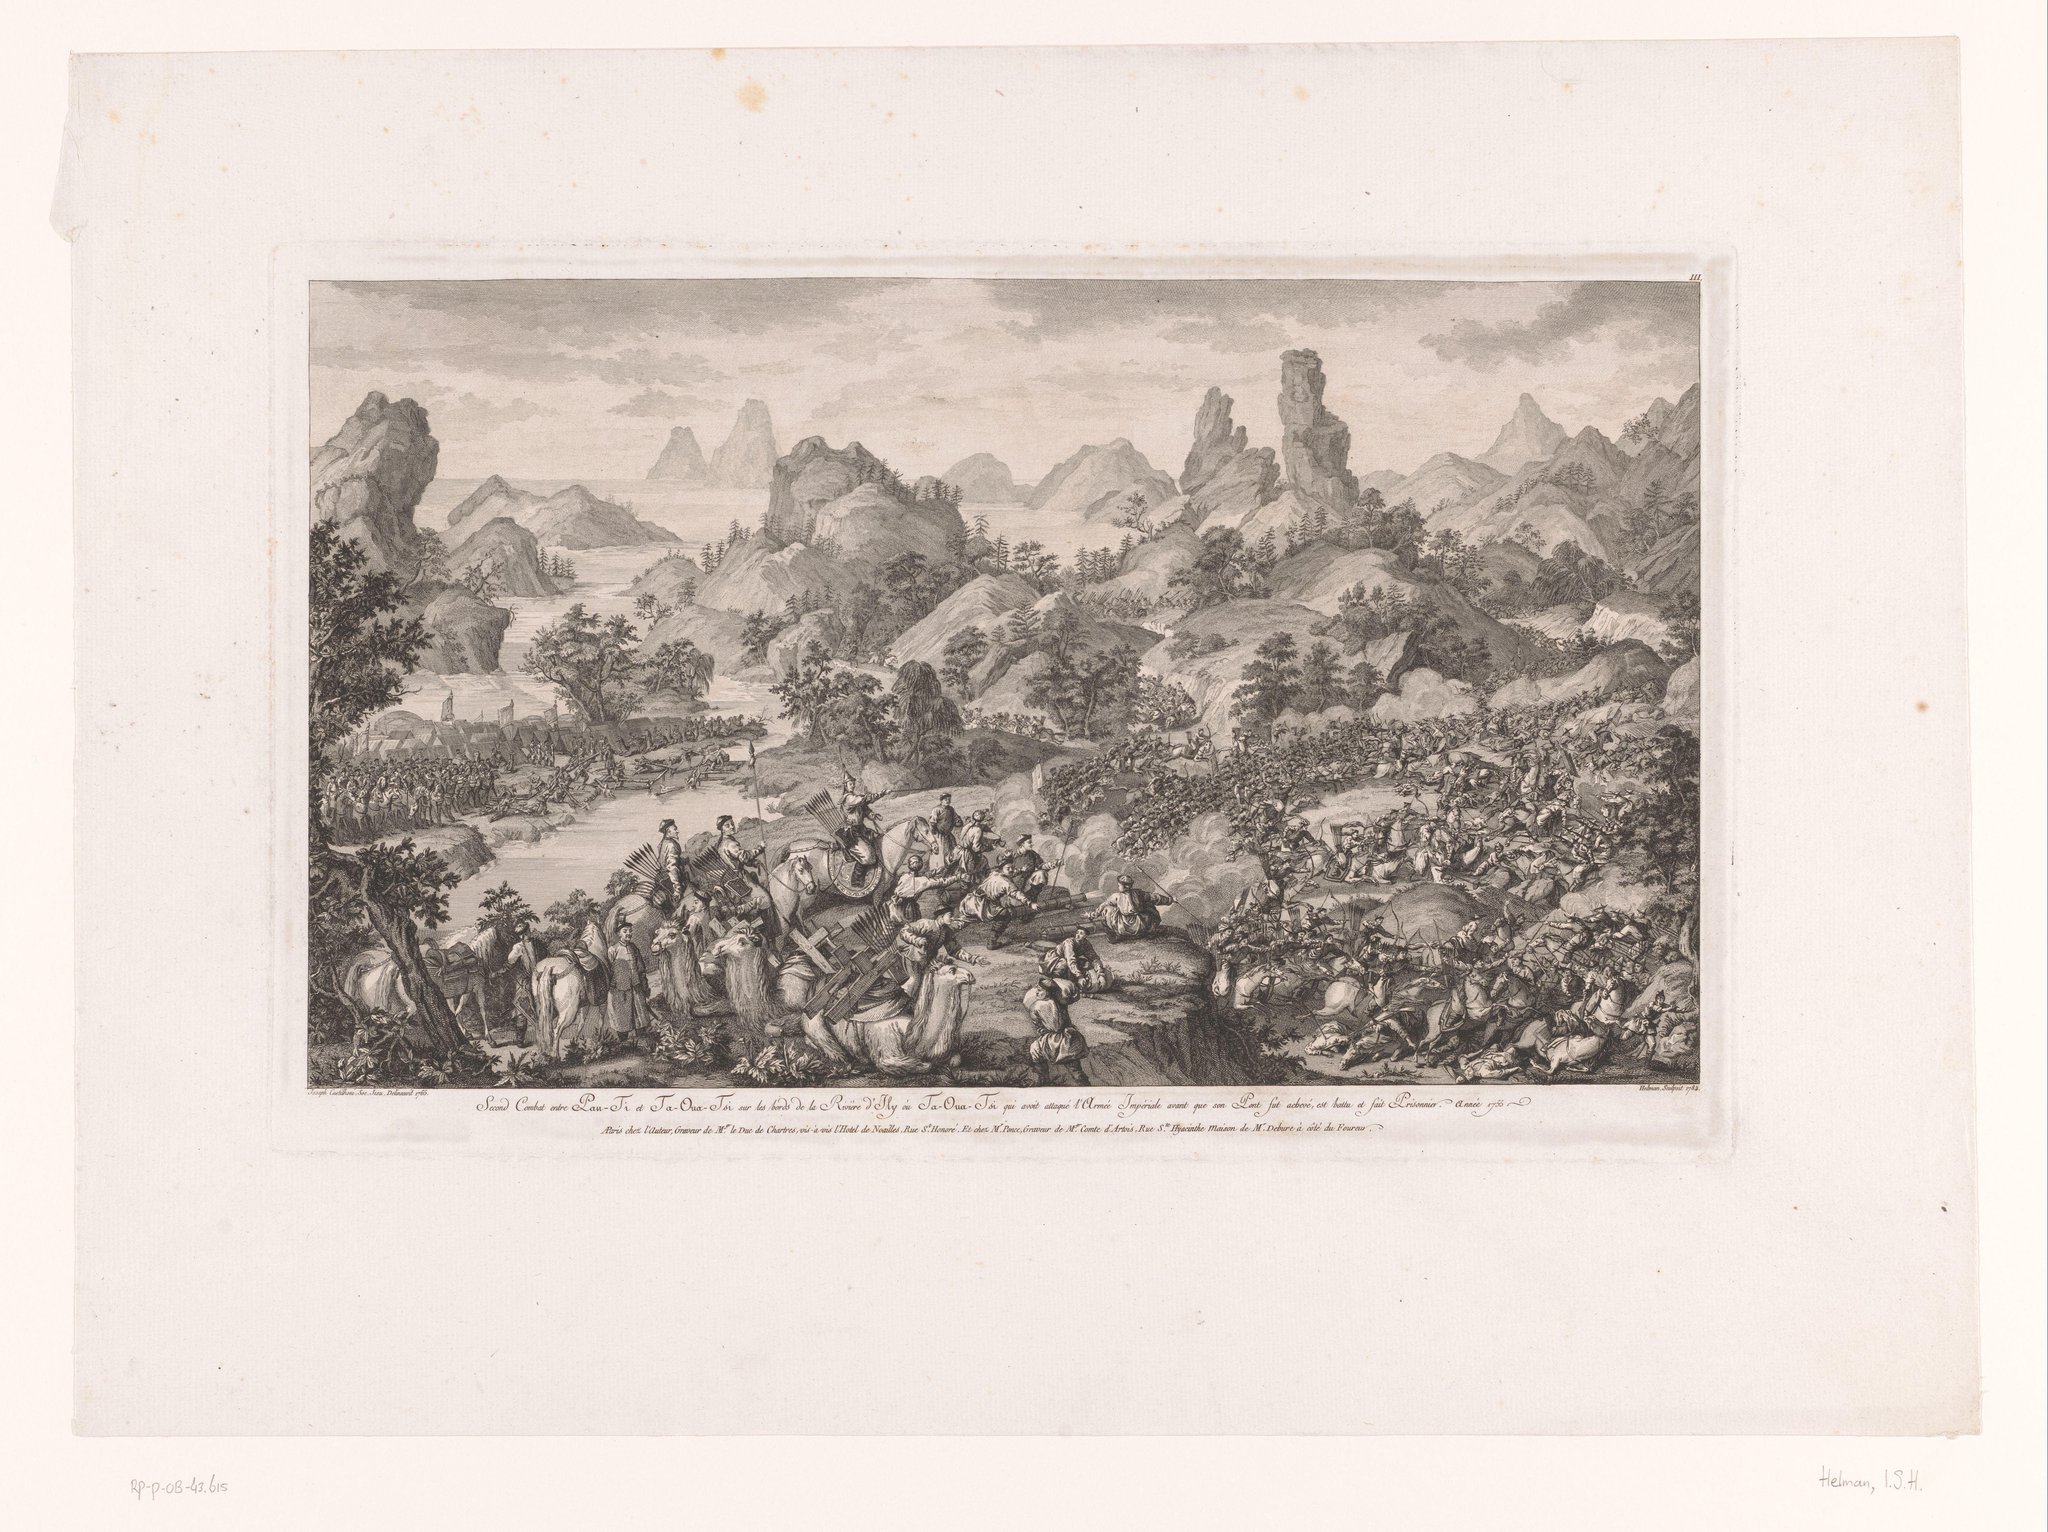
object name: print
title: Slag bij de Dà, de tweede strijd tussen het Chinese leger en het leger van Ta-ou-Atsi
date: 1784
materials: paper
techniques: engraving, etching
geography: paris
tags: hoofed animals: camel, river, battle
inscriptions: collector's mark: Lugt 2228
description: Prent uit een versie van de serie 'Conquêtes de l' Empereur de la Chine' met afbeeldingen van de veroveringen van keizer Qianlong van China, uitgegeven door Helman tussen 1783-1785. Voor twee bladen met bijbehorende beschrijvende tekst, zie RP-P-OB-43.629 en RP-P-OB-43.630.